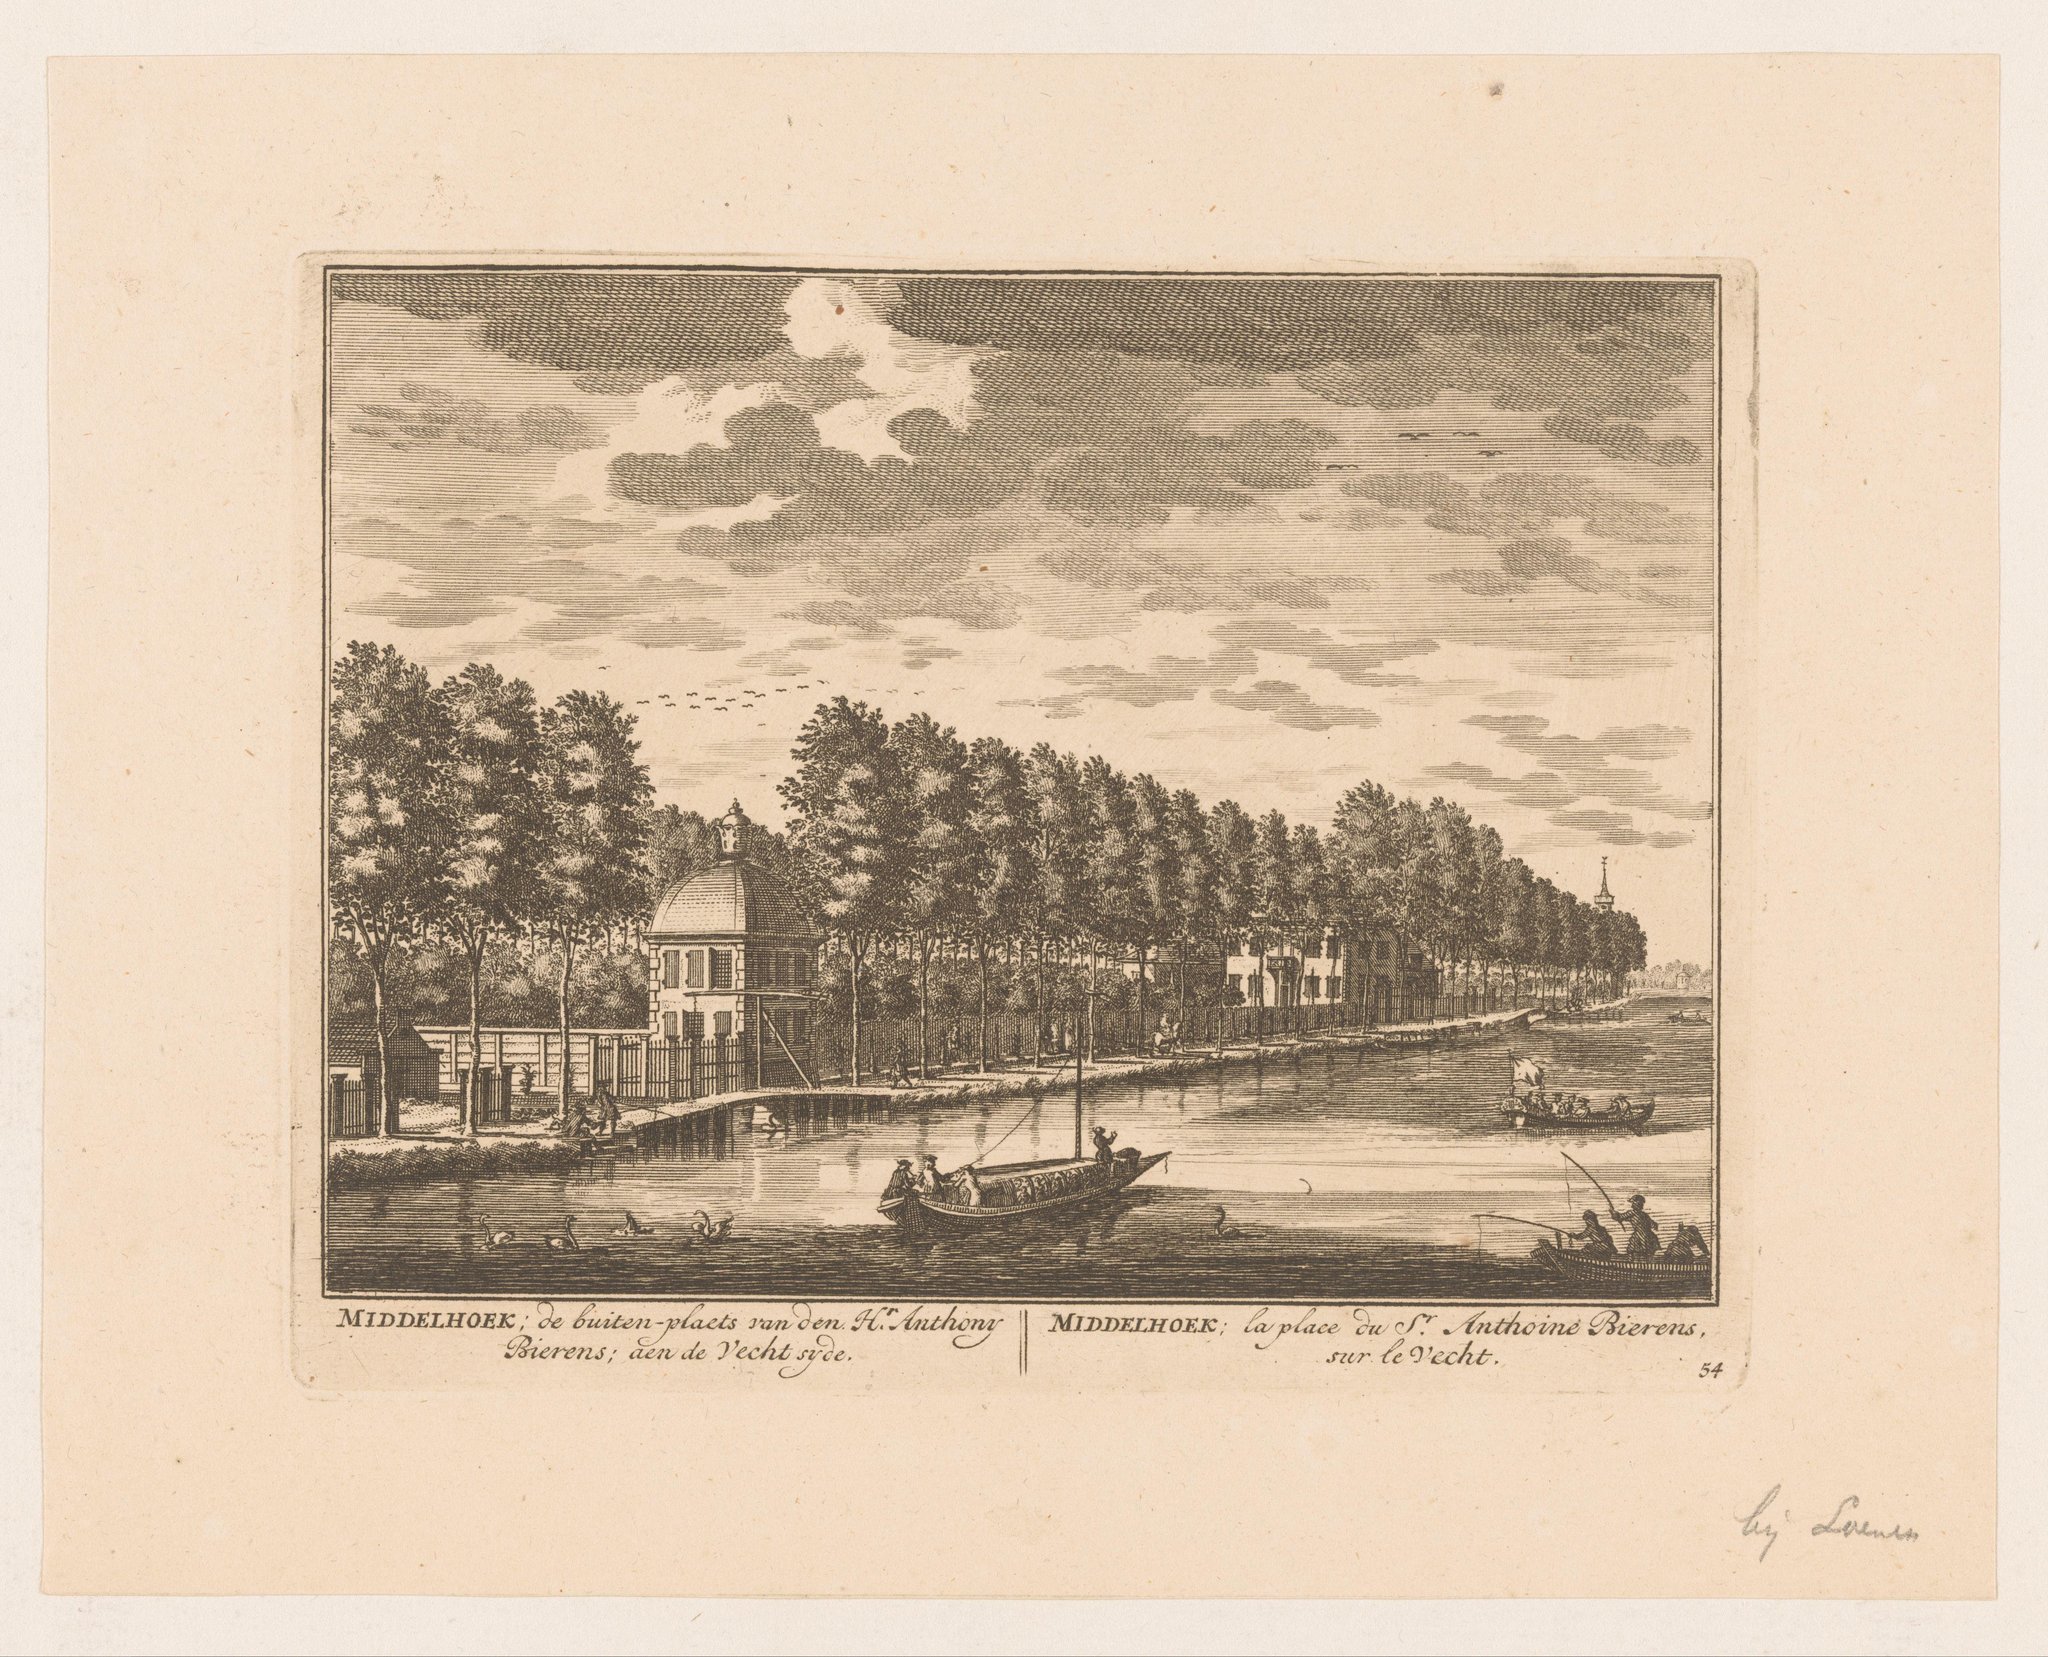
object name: print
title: Gezicht op Middelhoek aan de Vecht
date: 1719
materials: paper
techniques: etching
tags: river, rural housing, e.g. country-house, villa, cottage, vecht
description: Prent uit: De zegepraalende Vecht, vertoonende verscheidene gesichten van lustplaatsen, heeren huysen en dorpen, beginnende van Uitrecht en met Muyden besluytende. Amsterdam: Wed. Nicolaes Visscher, 1719.